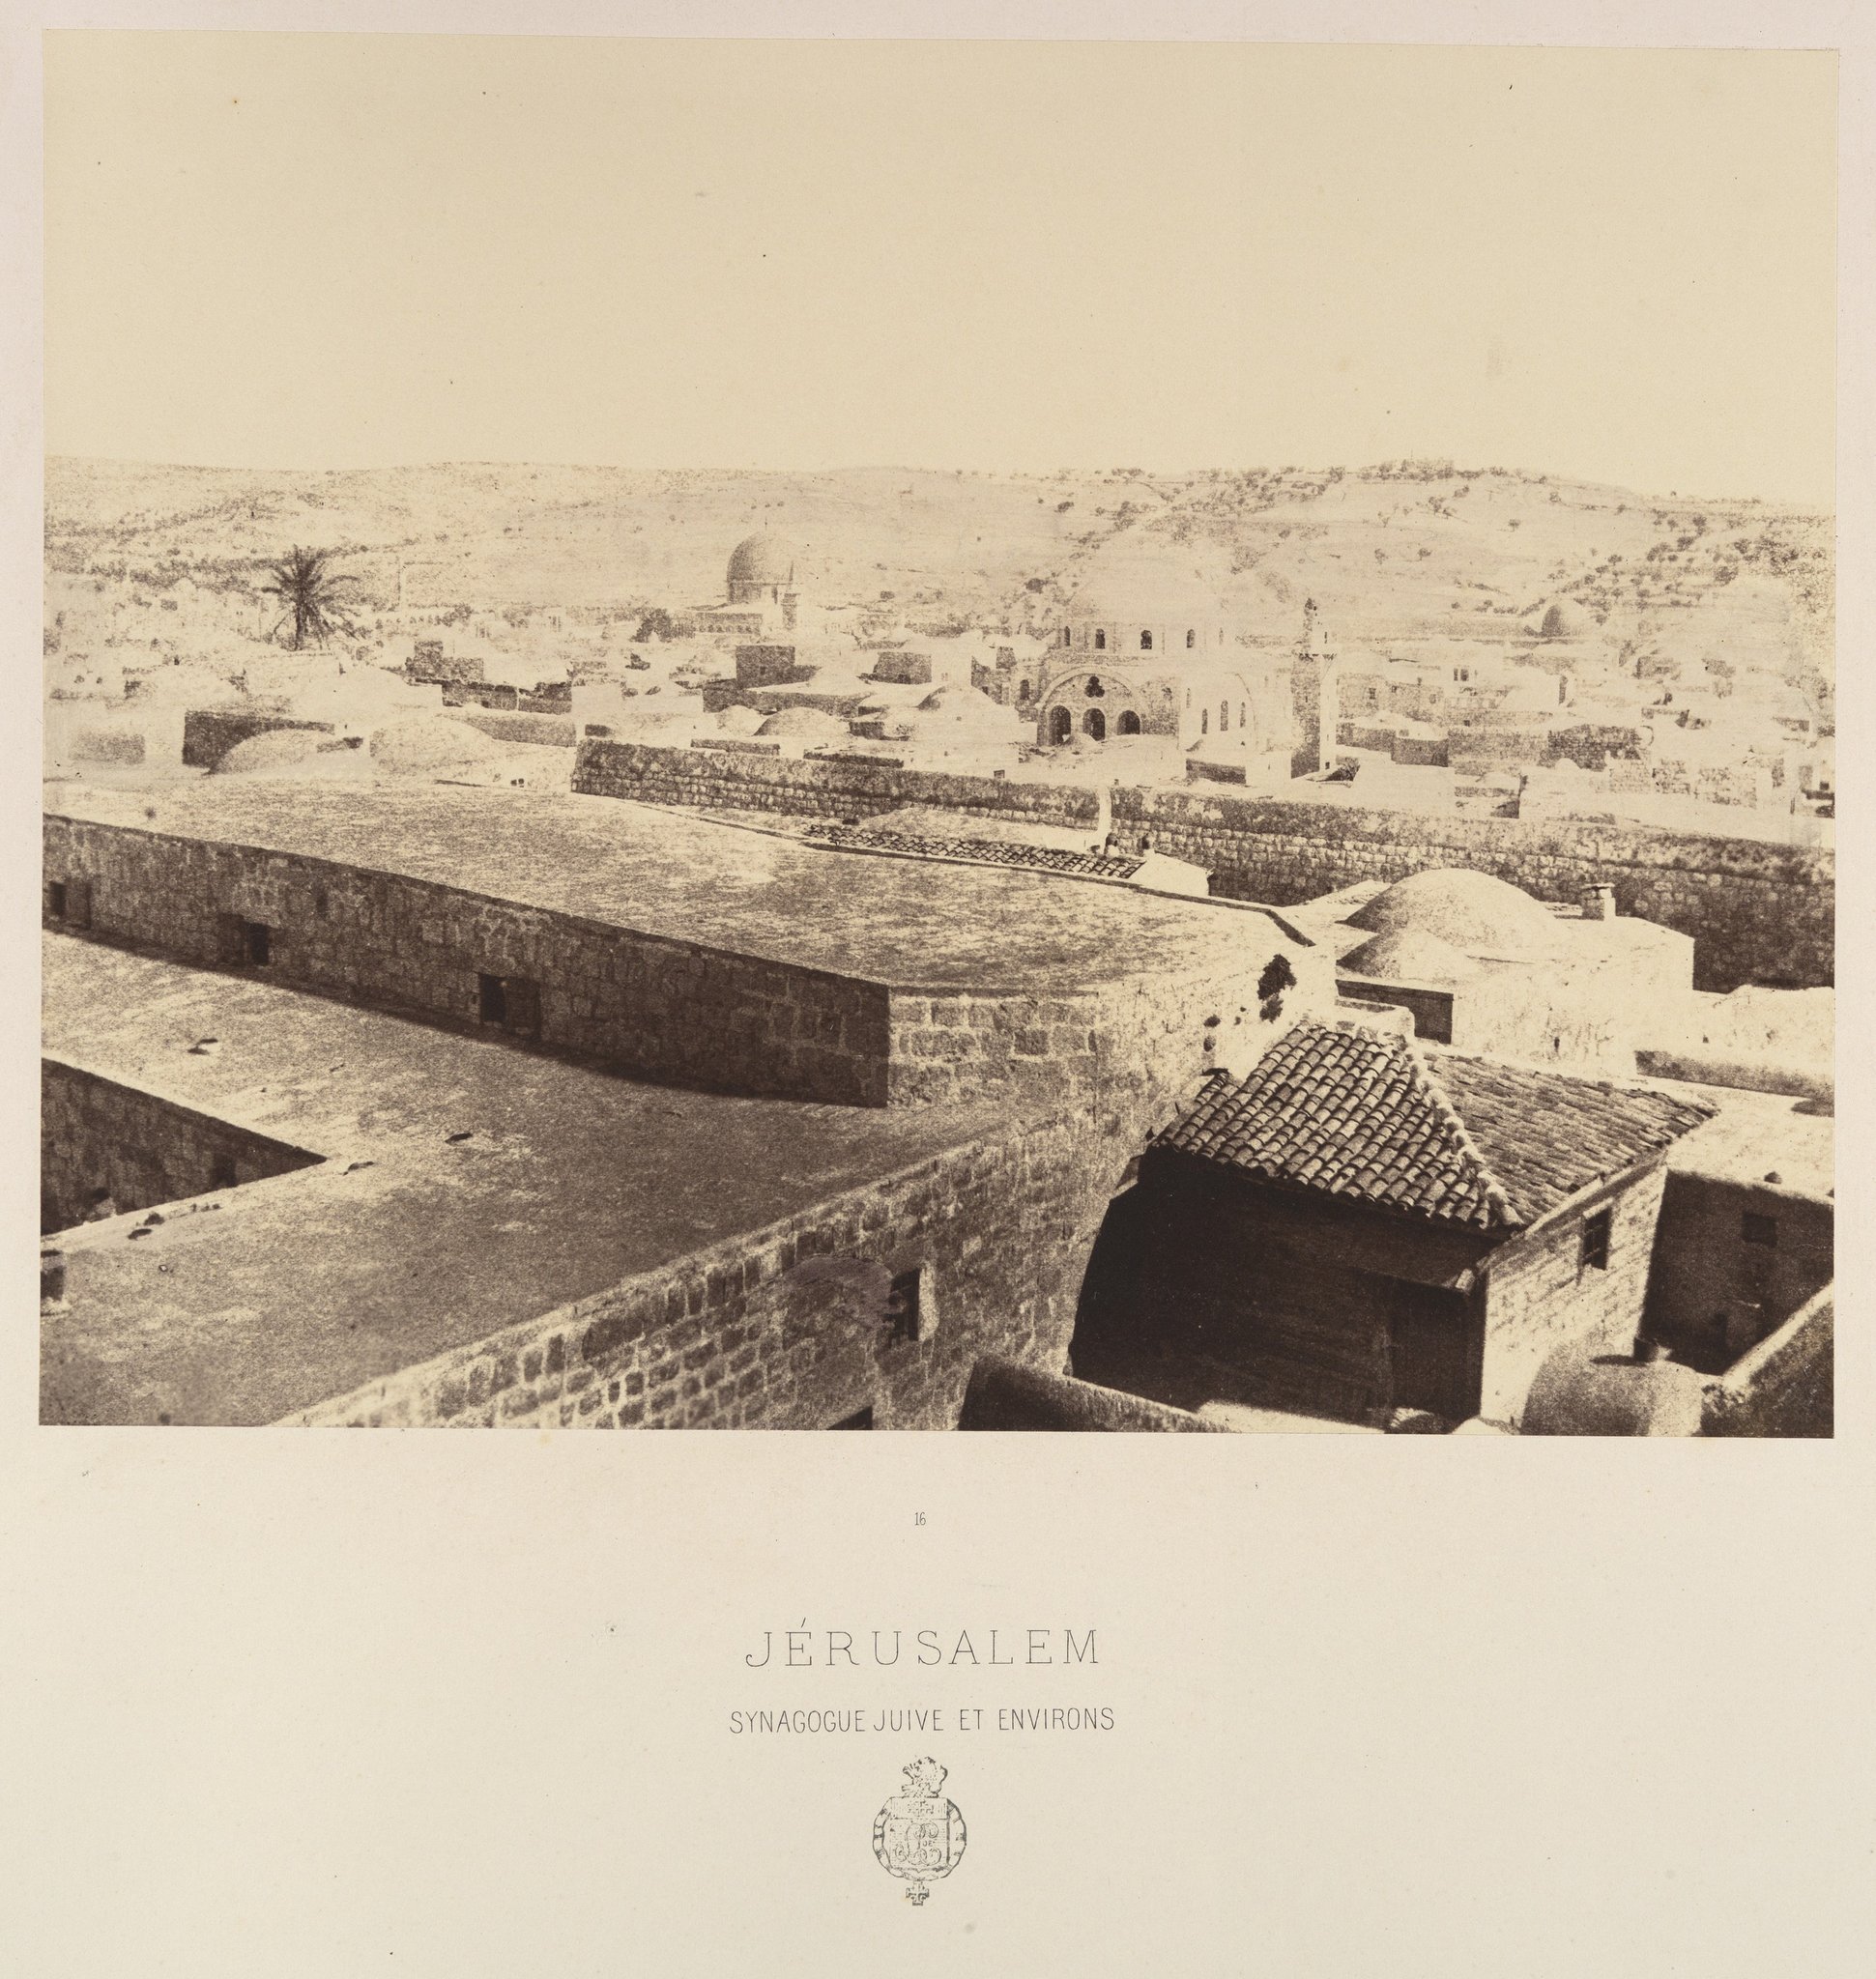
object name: photograph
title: Jérusalem. Synagogue juive et environs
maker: louis de clercq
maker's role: artist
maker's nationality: french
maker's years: 1837-1901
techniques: albumen silver print, paper negative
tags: architecture,cities